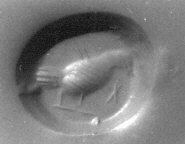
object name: stamp seal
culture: sasanian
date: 201-700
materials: stone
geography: iran or mesopotamia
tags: birds